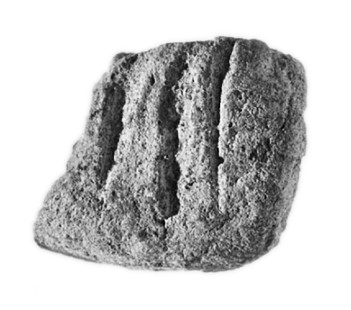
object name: sealing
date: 1981-1640 BCE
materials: mud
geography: egypt